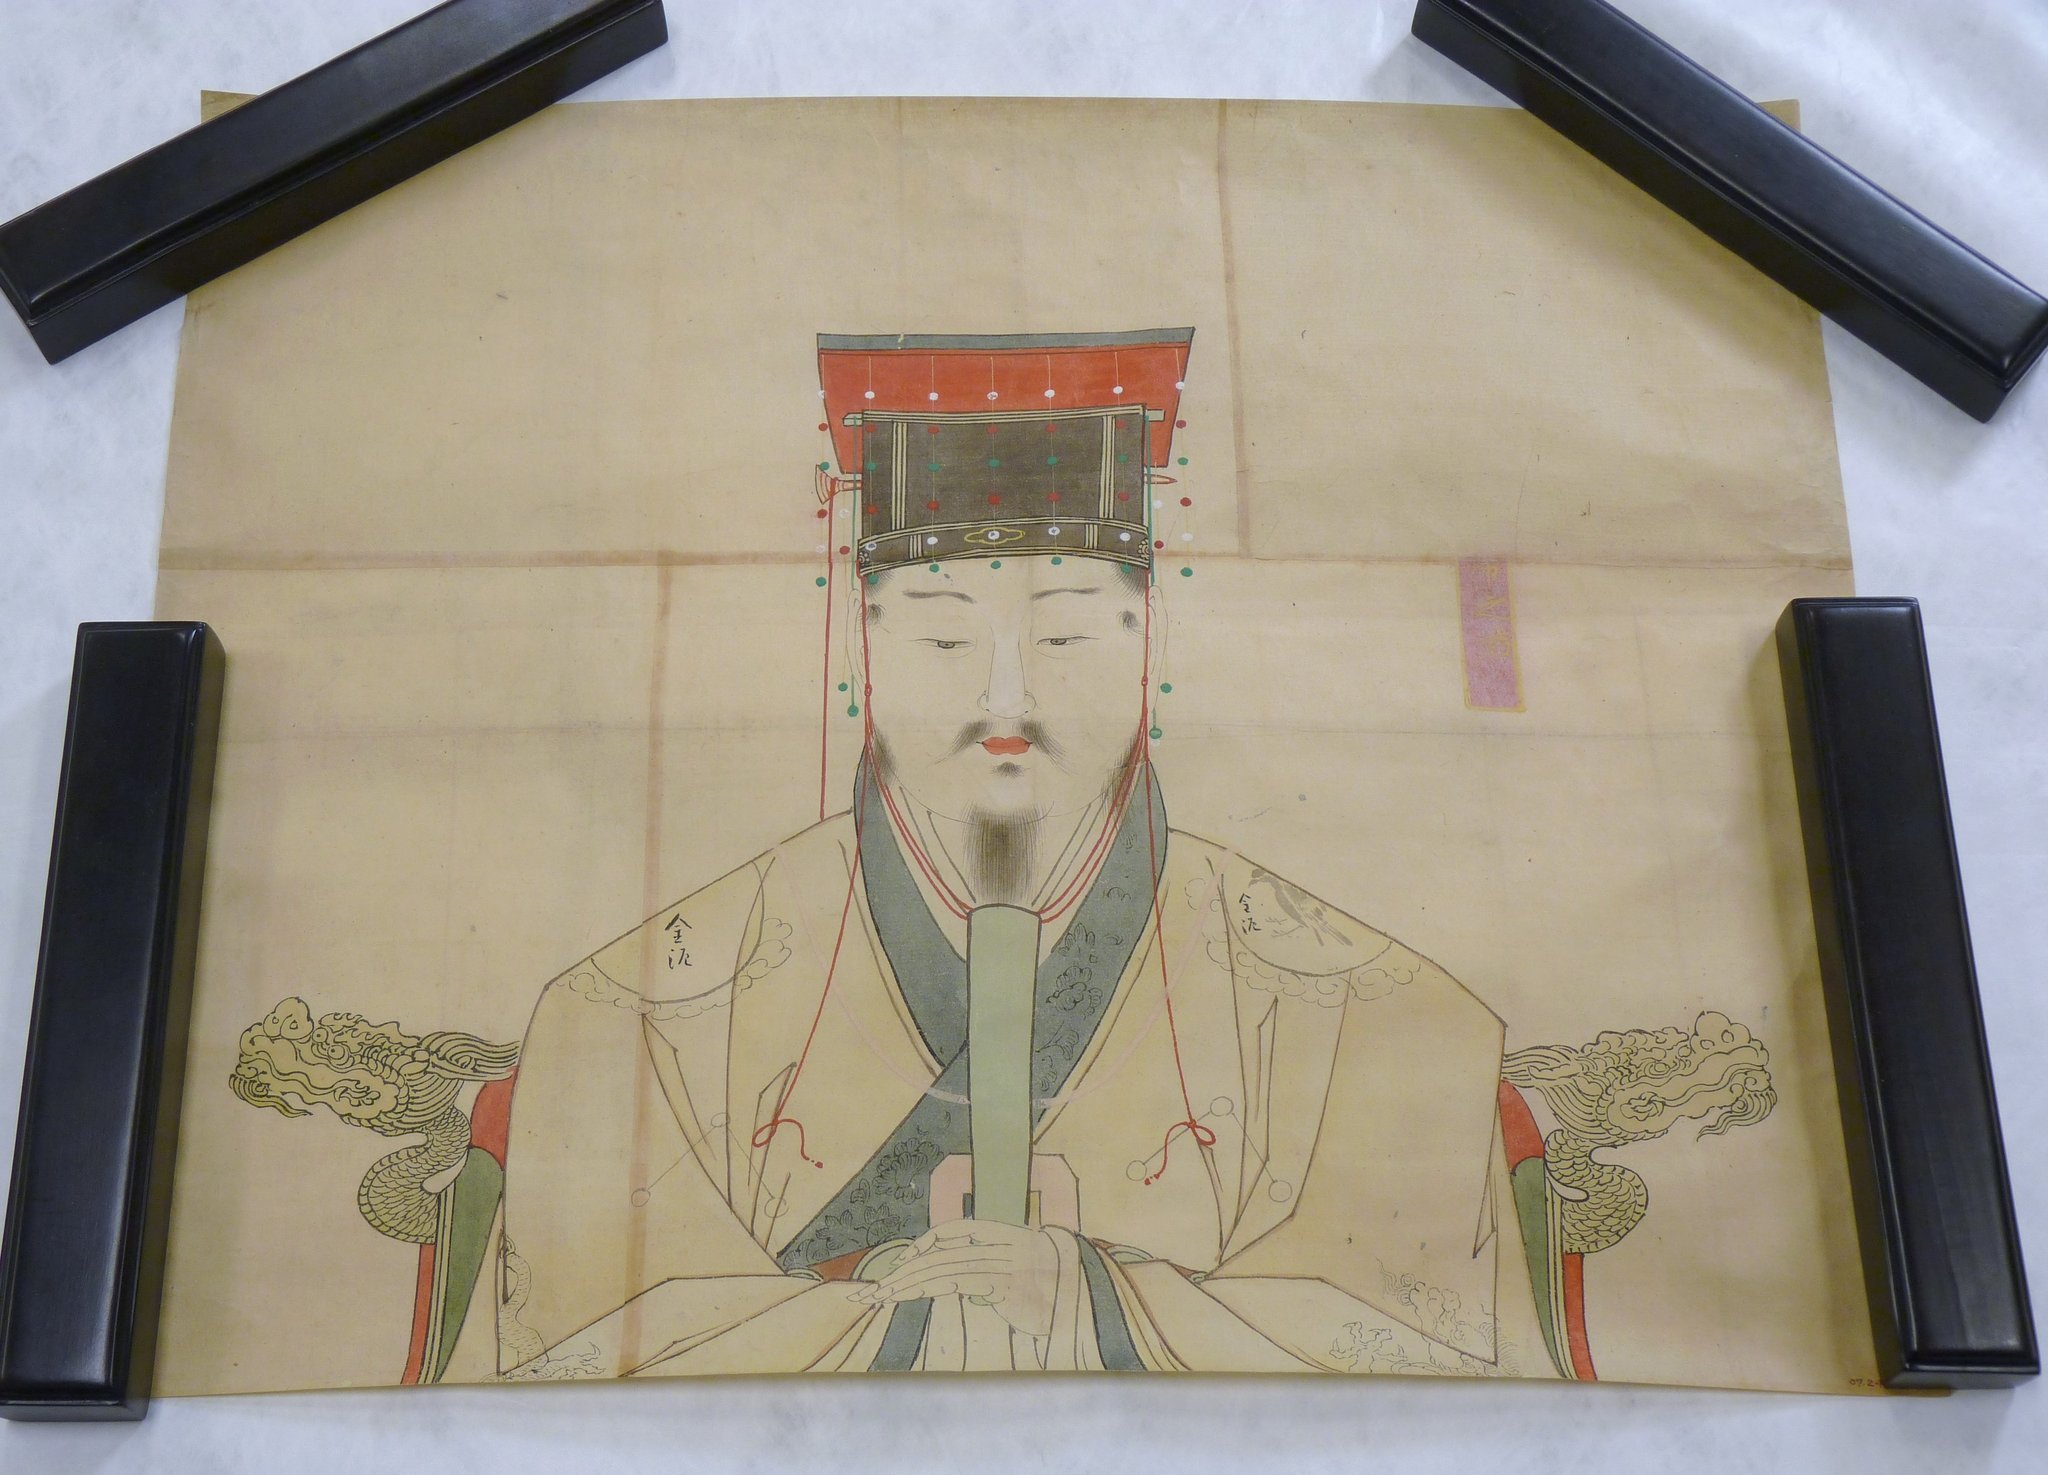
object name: drawing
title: Japanese Drawing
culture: japanese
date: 1801-1833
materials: paper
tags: men,portraits